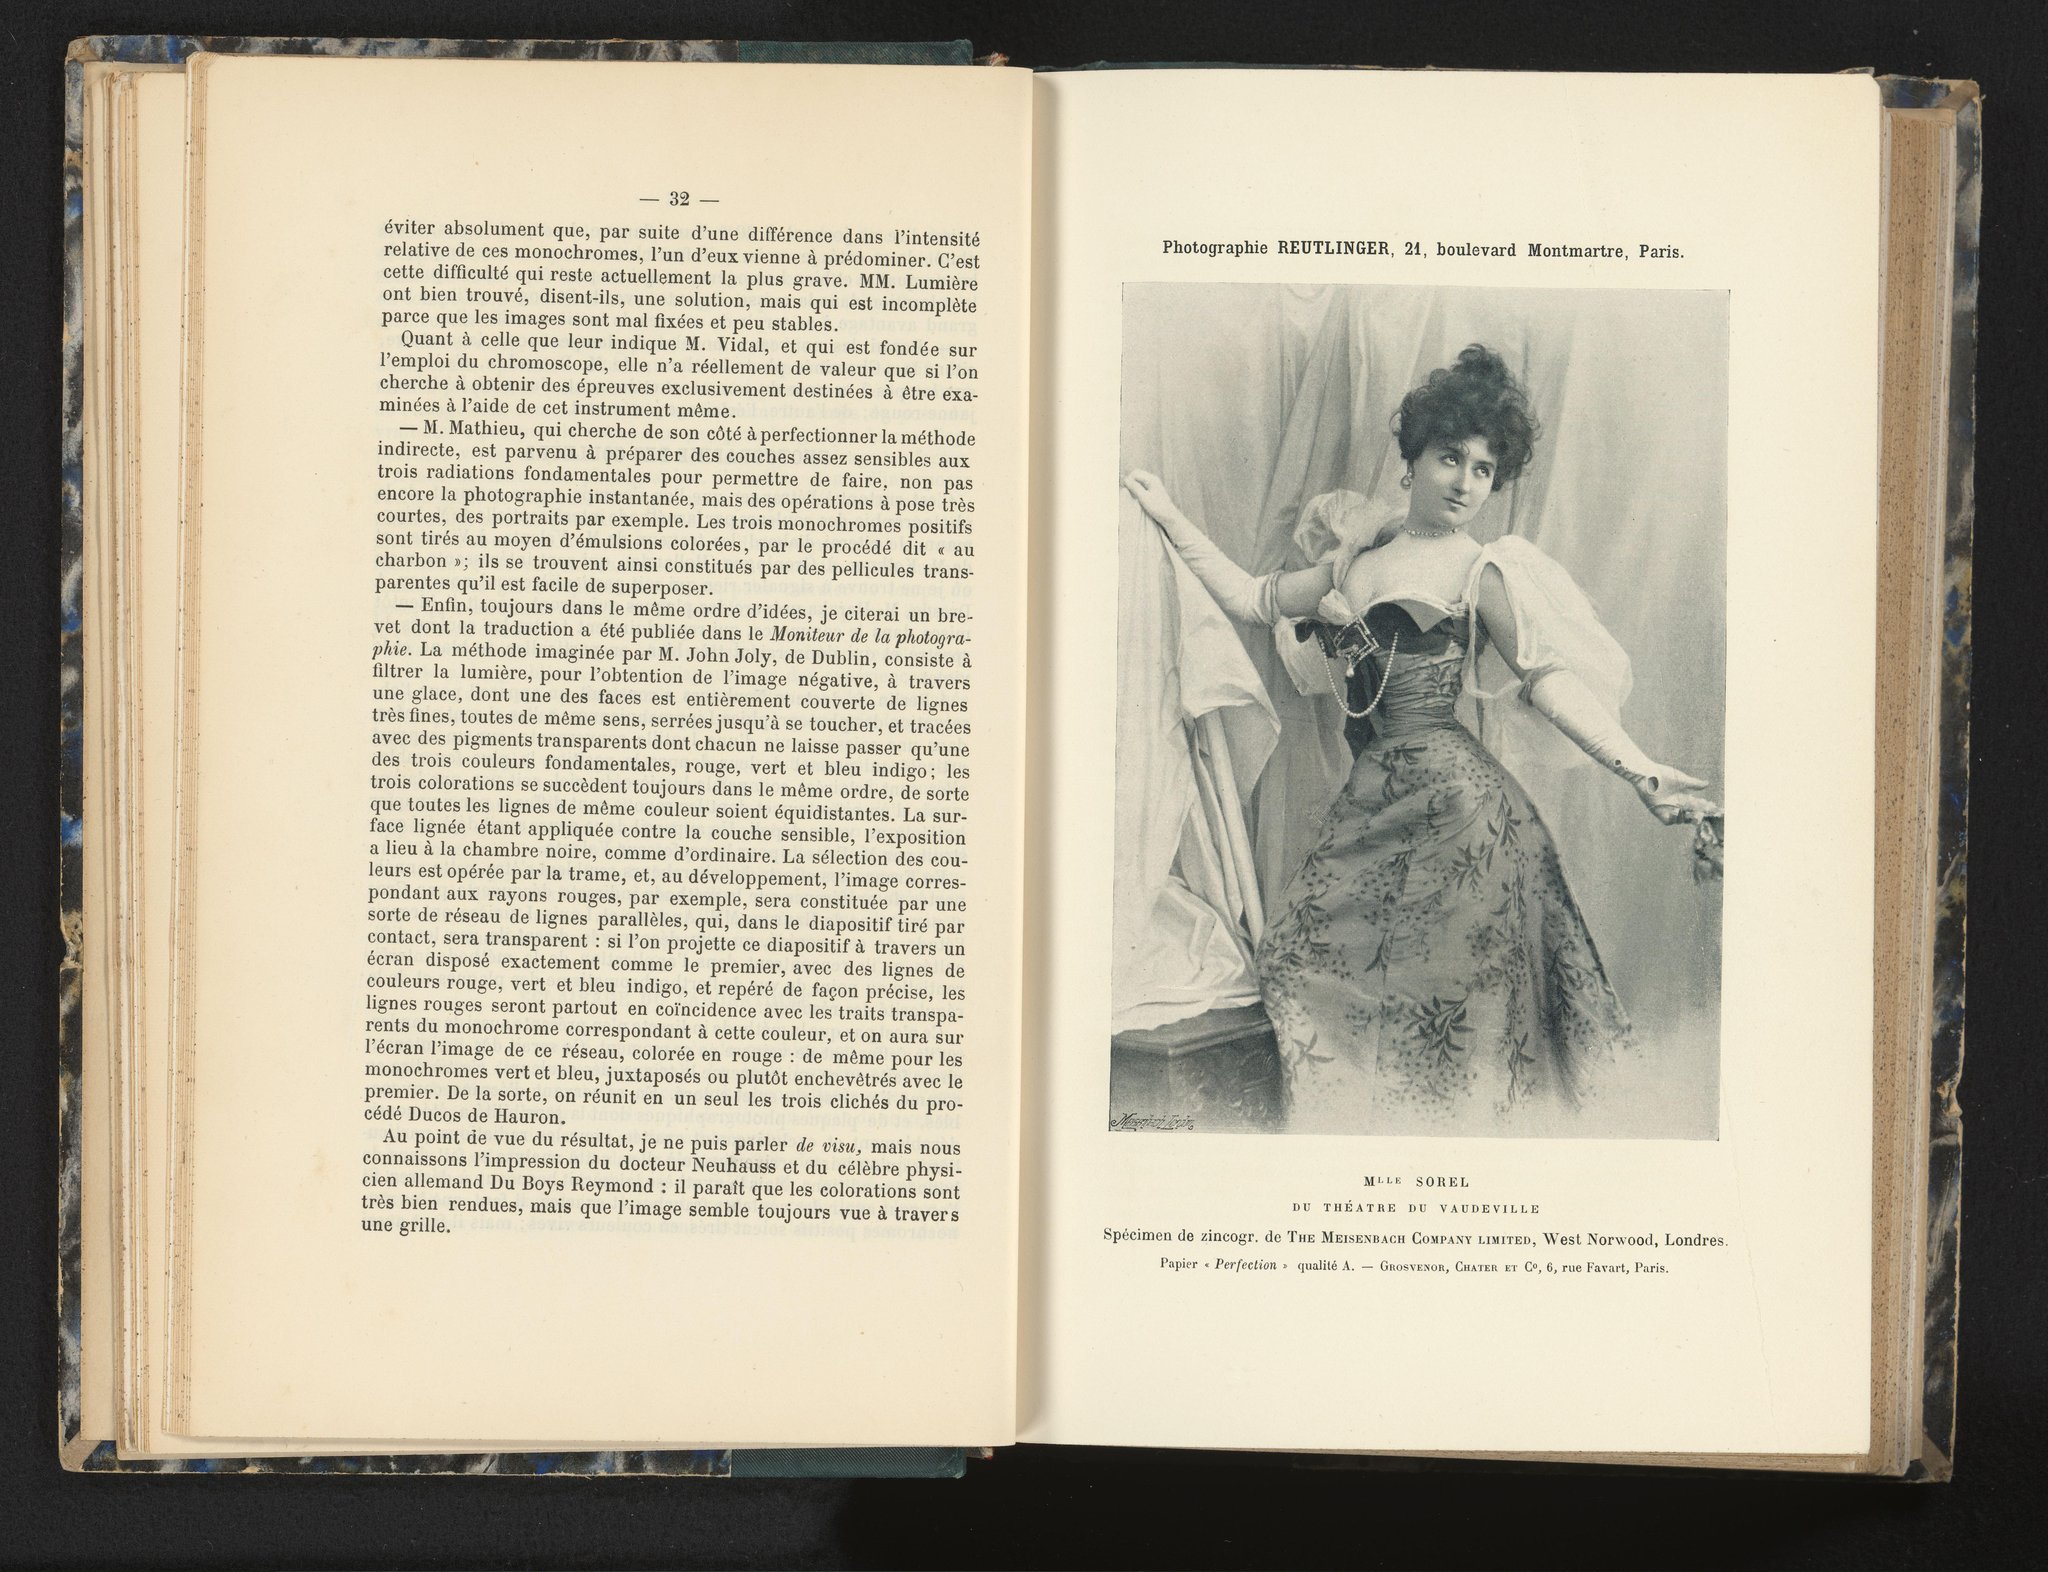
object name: page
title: Mlle Sorel du Théatre du Vaudeville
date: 1891-1896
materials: paper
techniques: autotype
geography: london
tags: historical persons - bb - woman, portrait of actor, actress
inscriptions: inscription: ‘Spécimen de zincogr. de The Meisenbach Company Limited, West-Norwood, Londres./ Papier < Perfection >, qualité A. - Grosvenor, Chater et Co, 6, rue Favart, Paris.’